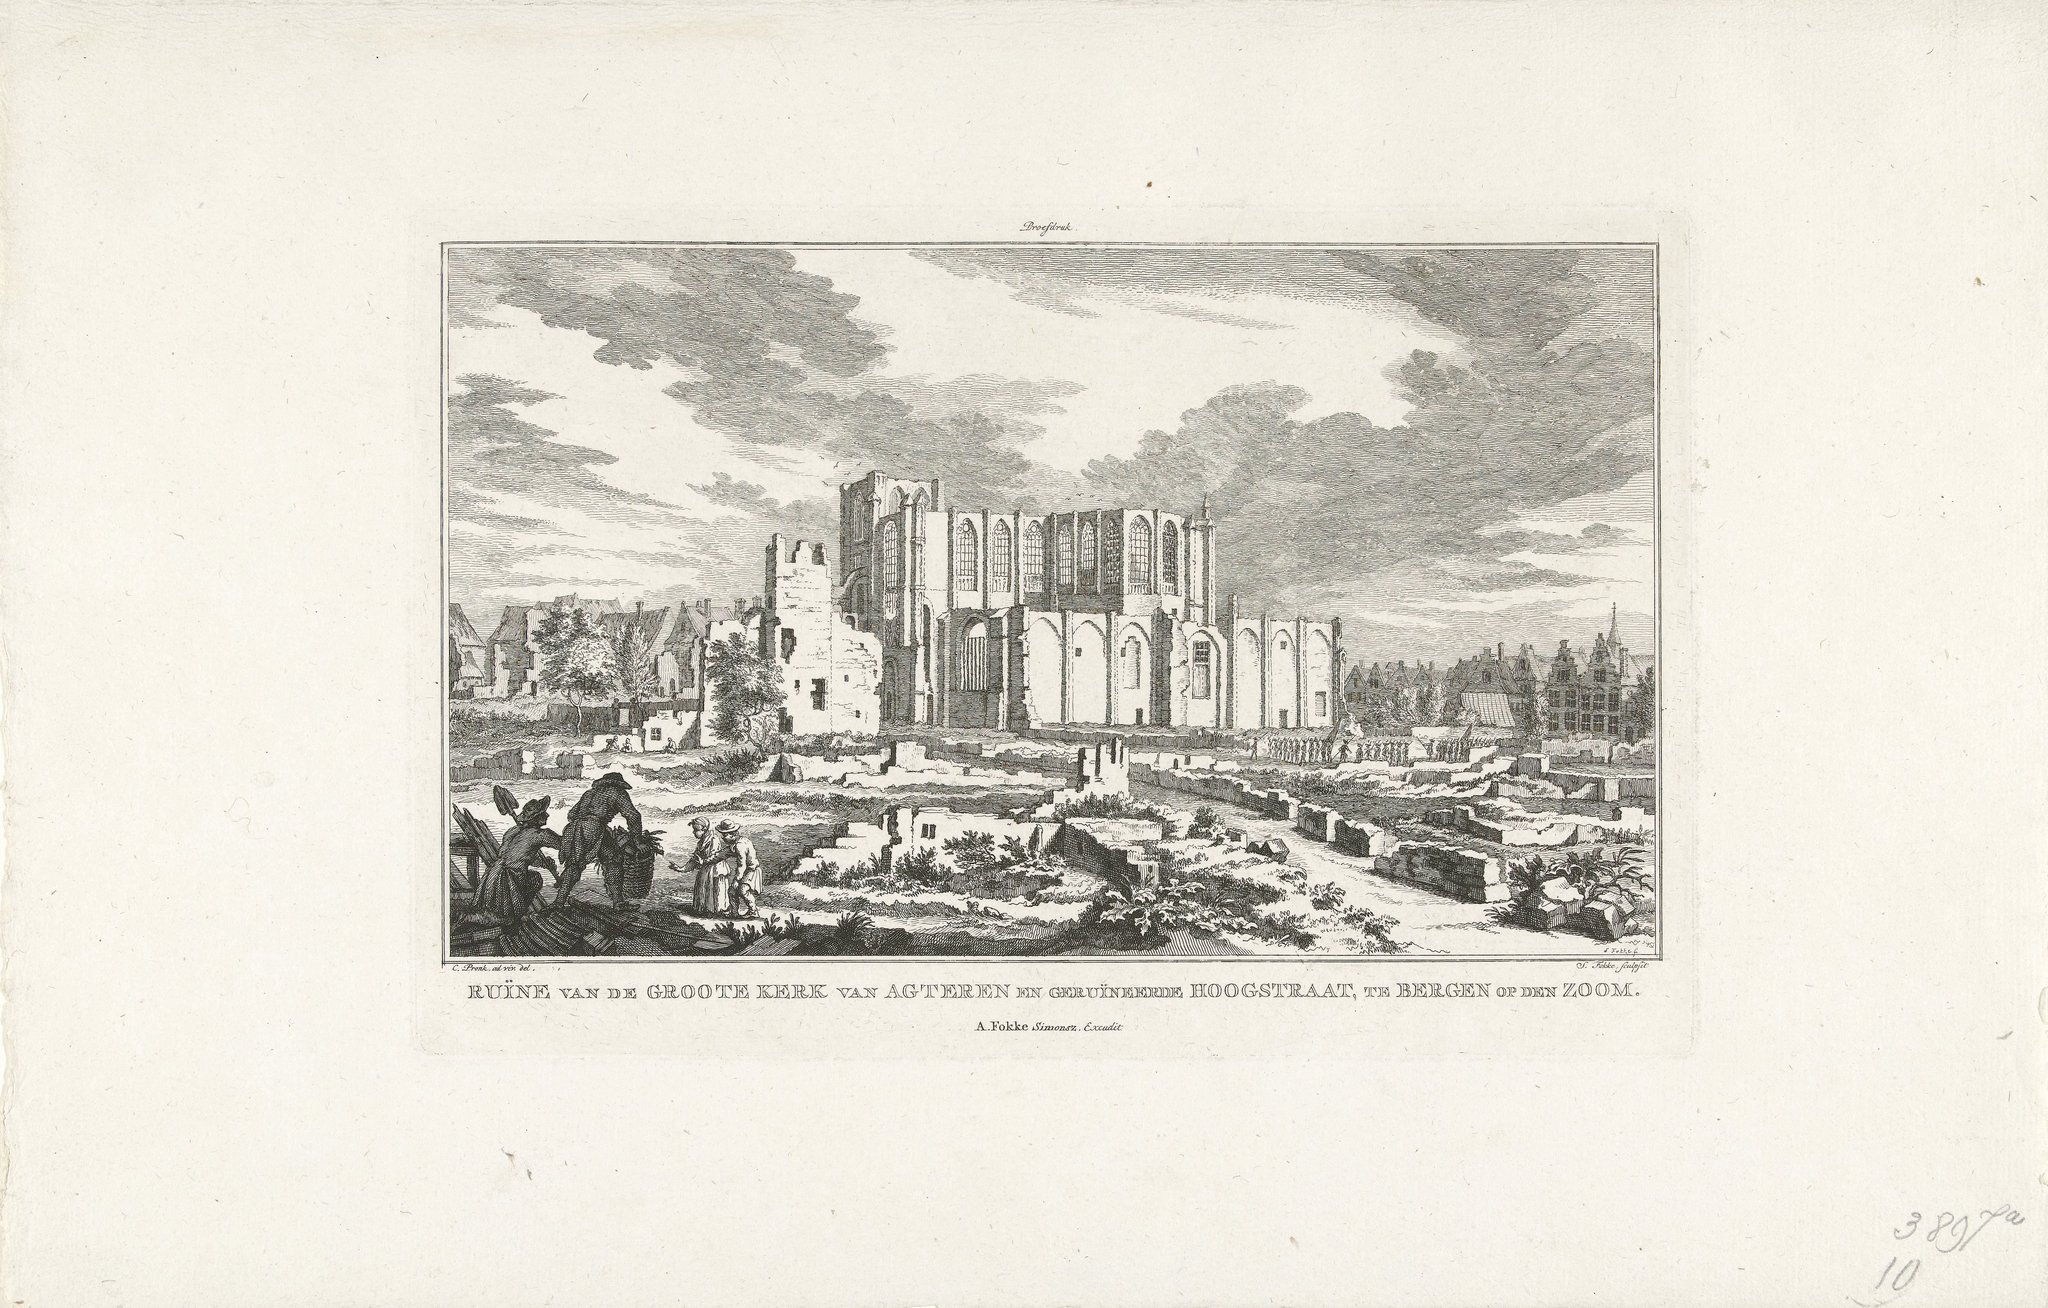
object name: book illustration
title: Tien gezichten van de ruïnes na het beleg en de verwoesting van Bergen op Zoom in 1747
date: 1772-1780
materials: paper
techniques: etching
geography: northern netherlands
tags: ruin of church, monastery, etc., devastated, ruined place or city (~ warfare), bergen op zoom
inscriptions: collector's mark: Lugt 2228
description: Prent ook gebruikt in: Beschryving der stad Bergen op den Zoom (…). 1e druk. Amsterdam: Arend Fokke Simonsz., 1780. Muller geeft aan dat de prenten door Simon Fokke in 1772 naar de tekeningen van Pronk uit 1748 zijn vervaardigd. In de Collecties Thuis in Brabant (collecties in Brabantse musea en archieven) is een ontwerptekening (met inv.nr.: BC-Tha oai:tha.uvt.nl:709121) voor deze prent in de serie bewaard met de annotatie: Hoogstraat. na t Leven geschest (sic) door C.Pronk 1748. opgetekent door S. Fokke 1772.